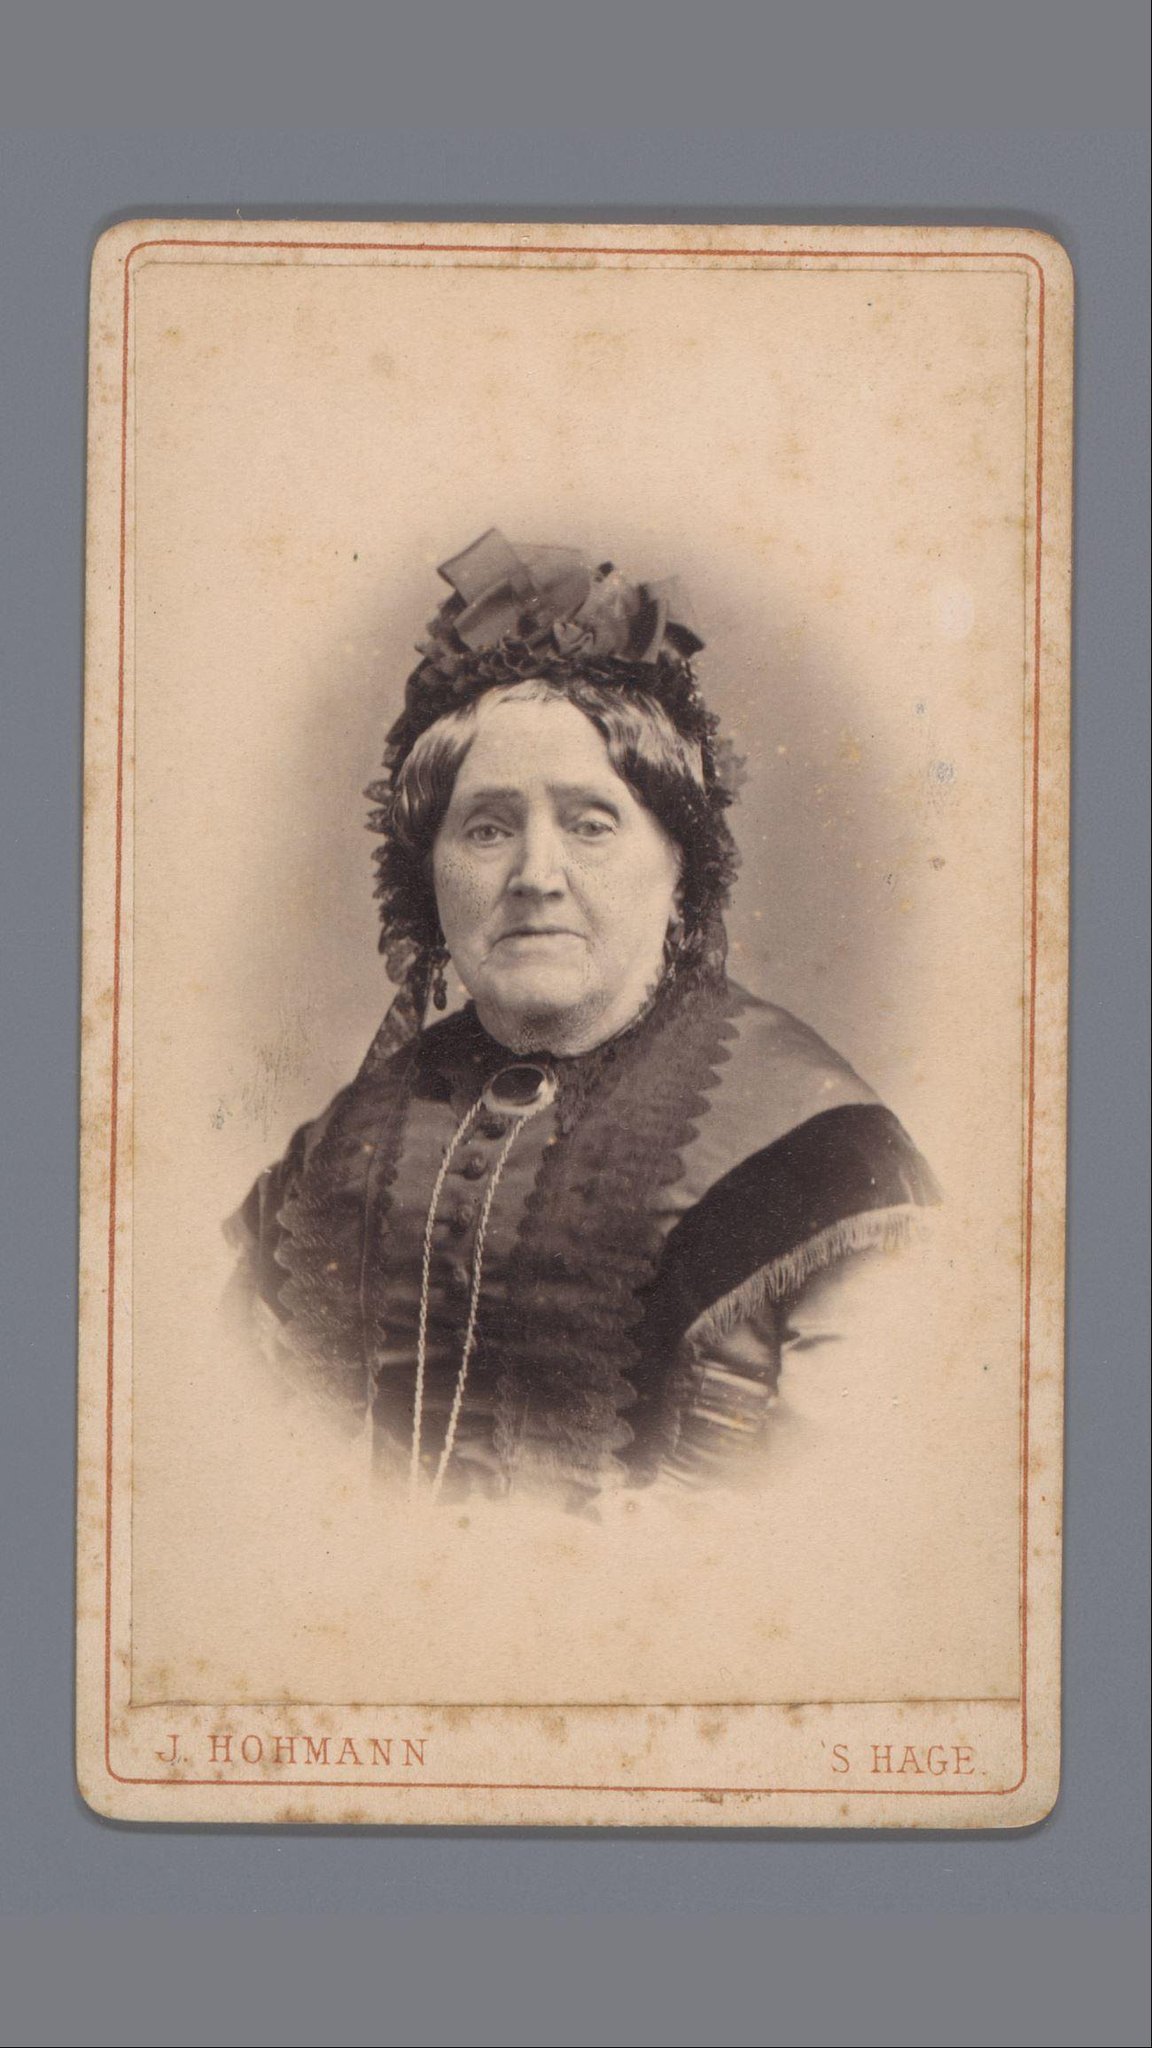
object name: photograph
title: Portret van een onbekende vrouw met een hoofddeksel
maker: jacob hohmann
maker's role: fotograaf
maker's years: 1833-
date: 1859-1893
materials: cardboard, paper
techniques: albumen print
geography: the hague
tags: historical persons - bb - woman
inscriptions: inscription: ‘H/ Photographisch Atelier/ van/ J. HOHMANN/ Willemstraat 59,/ 'S GRAVENHAGE./ Voor nabestellingen worden alle/ negativen bewaard.’